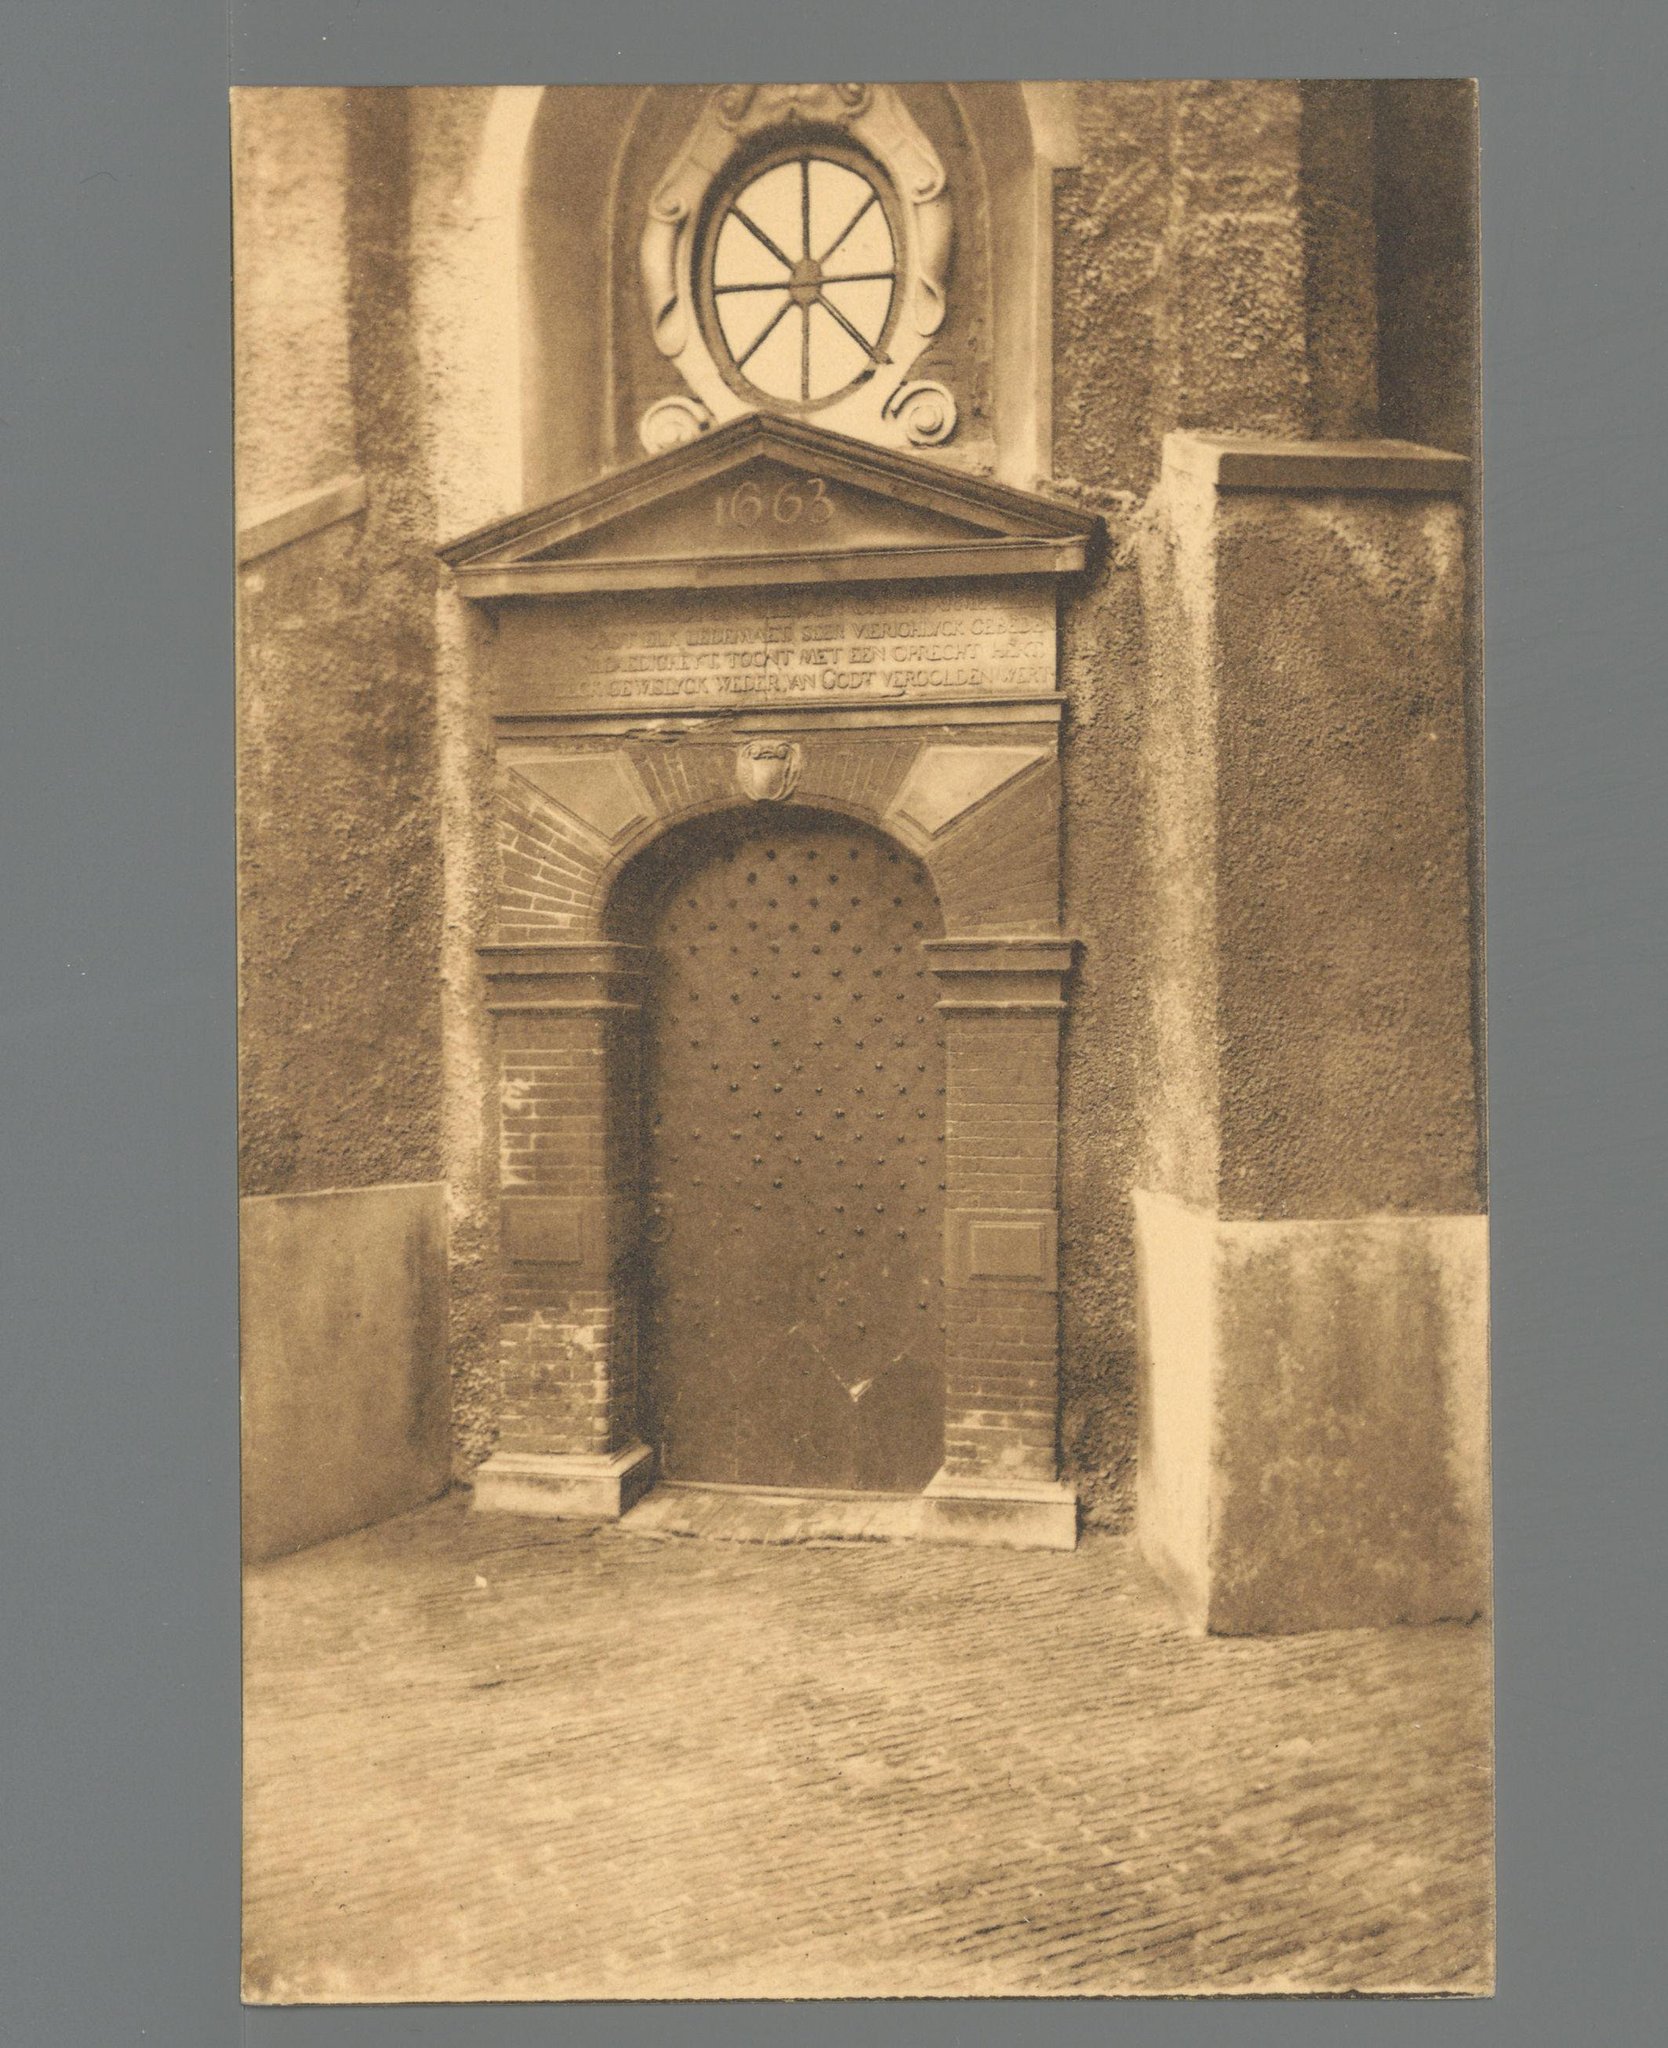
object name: ansichtkaart, prentbriefkaart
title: Het Broodpoortje - Leeuwarden. (...)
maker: Anonymous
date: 1905-1930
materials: cardboard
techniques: photograph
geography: zwolle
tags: church (exterior), gate, entrance